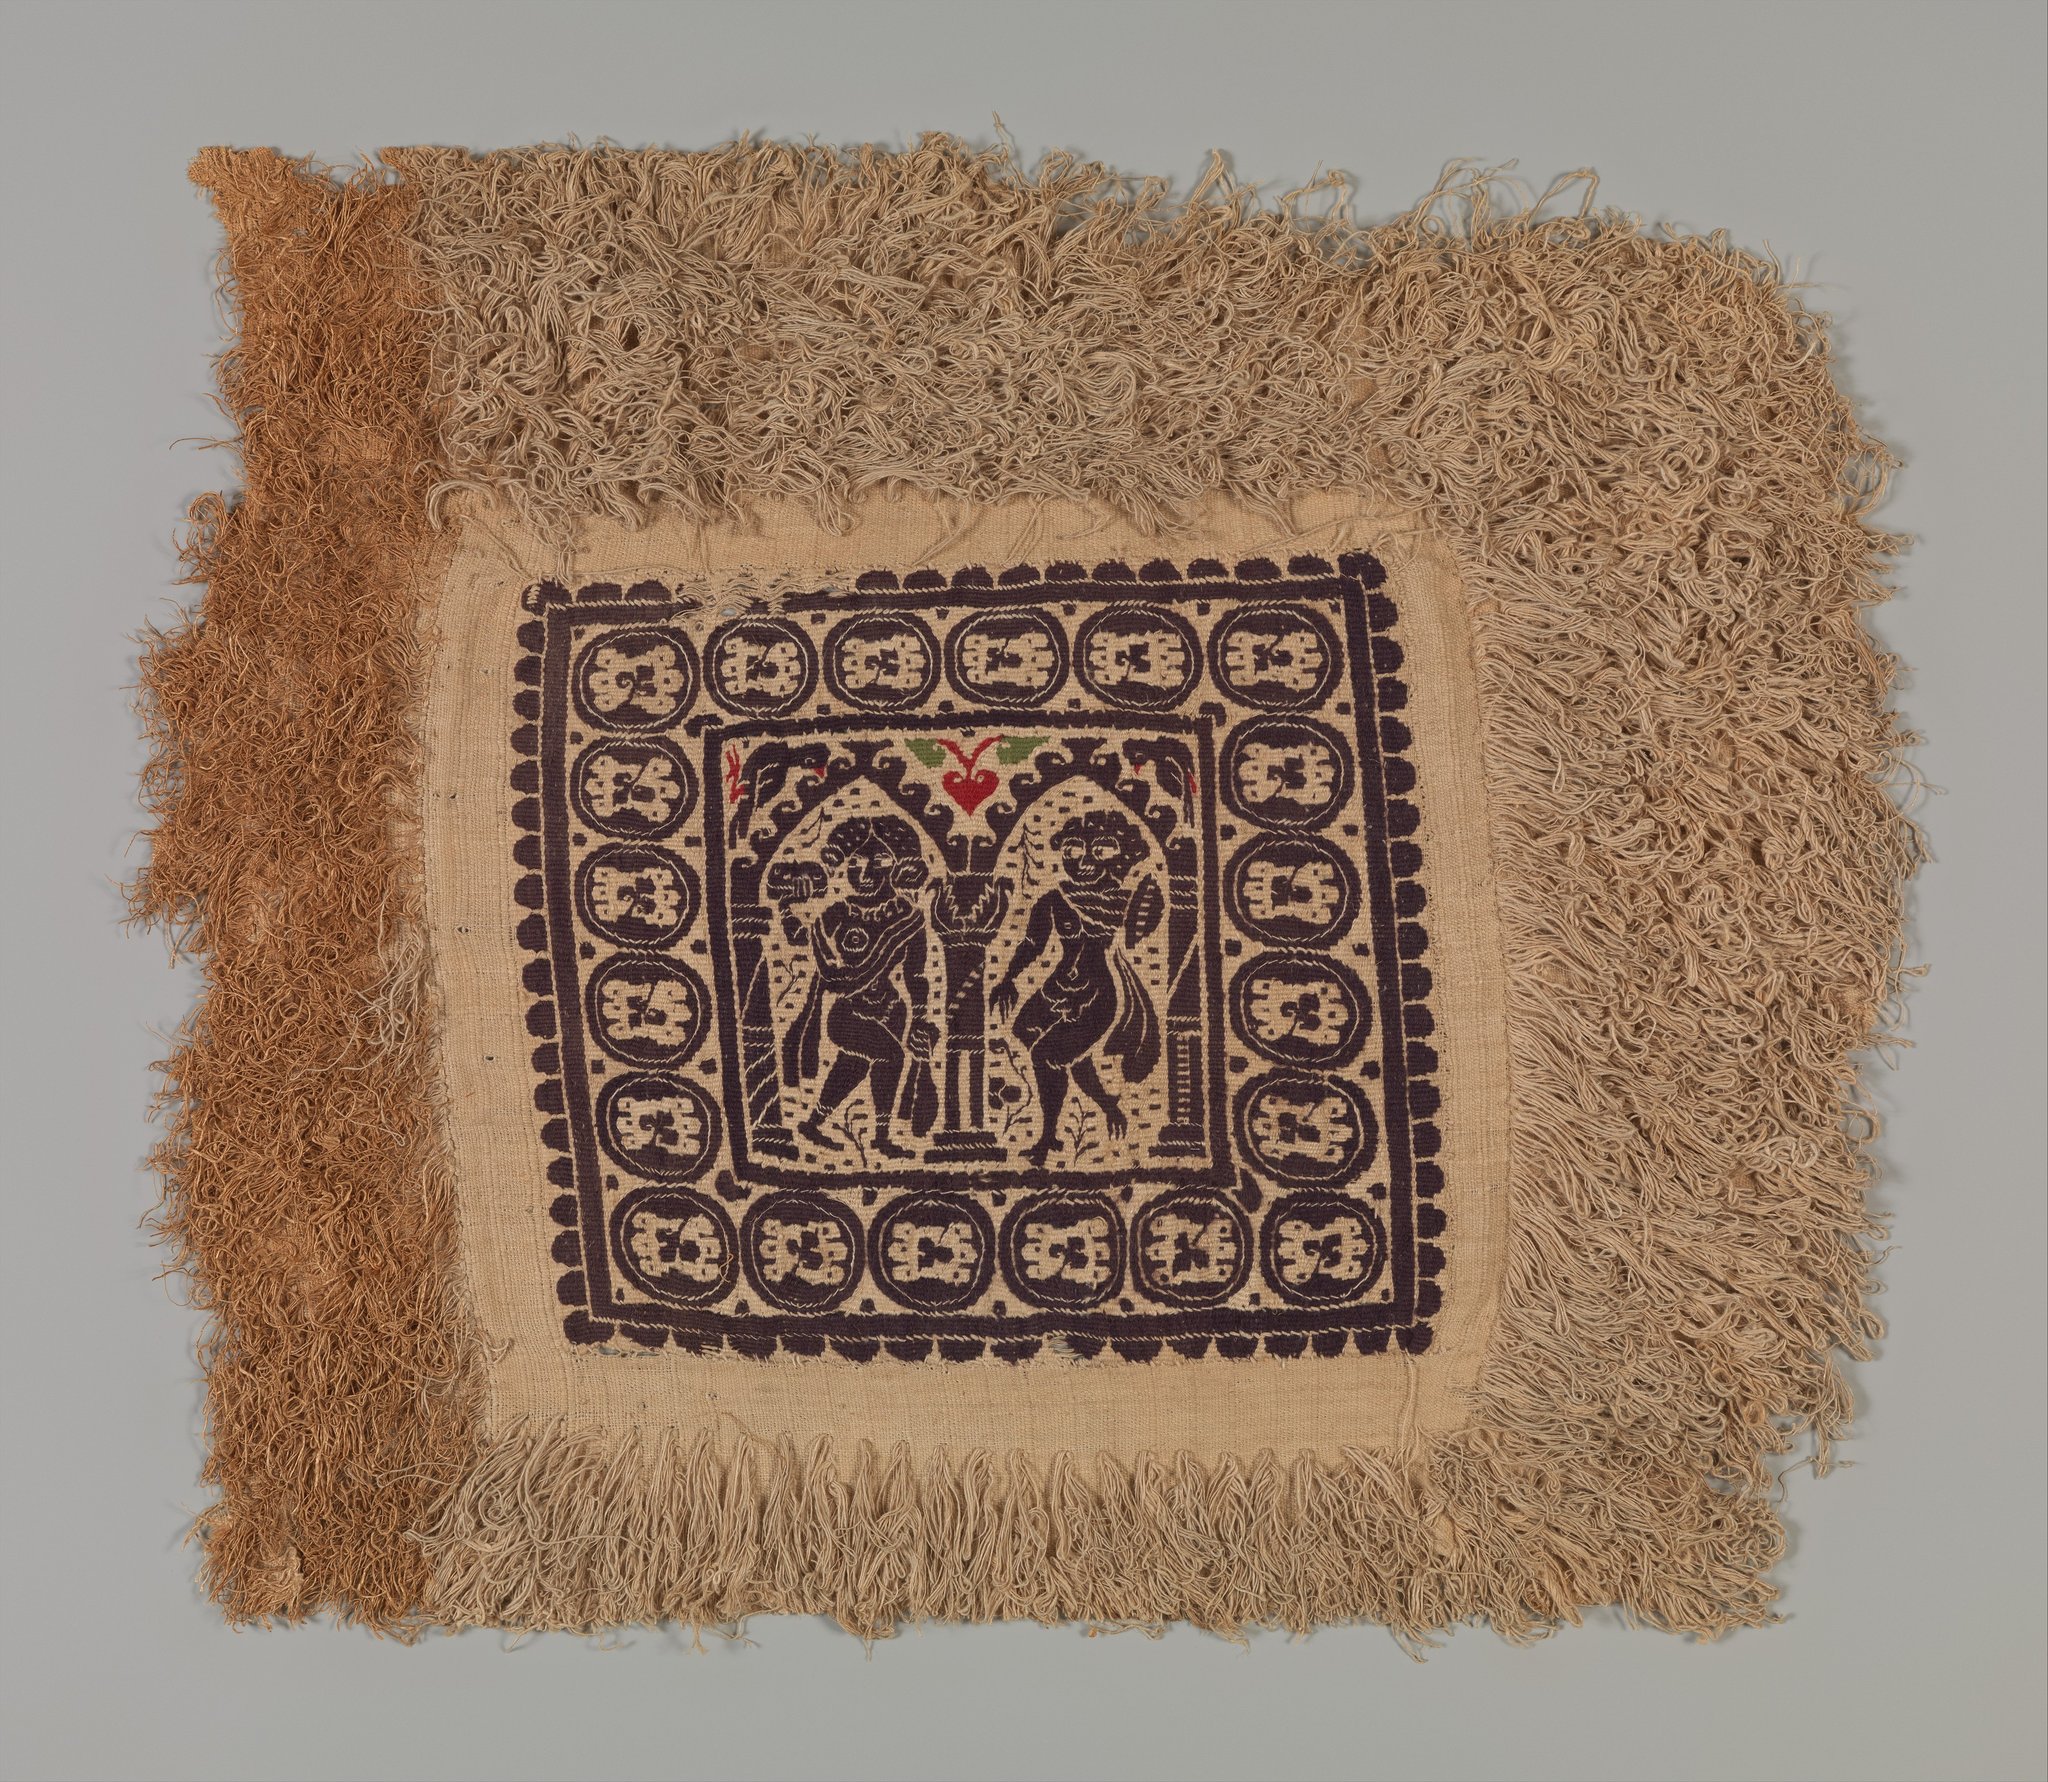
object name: textile fragment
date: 301-400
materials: linen, wool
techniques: weave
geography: egypt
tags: human figures